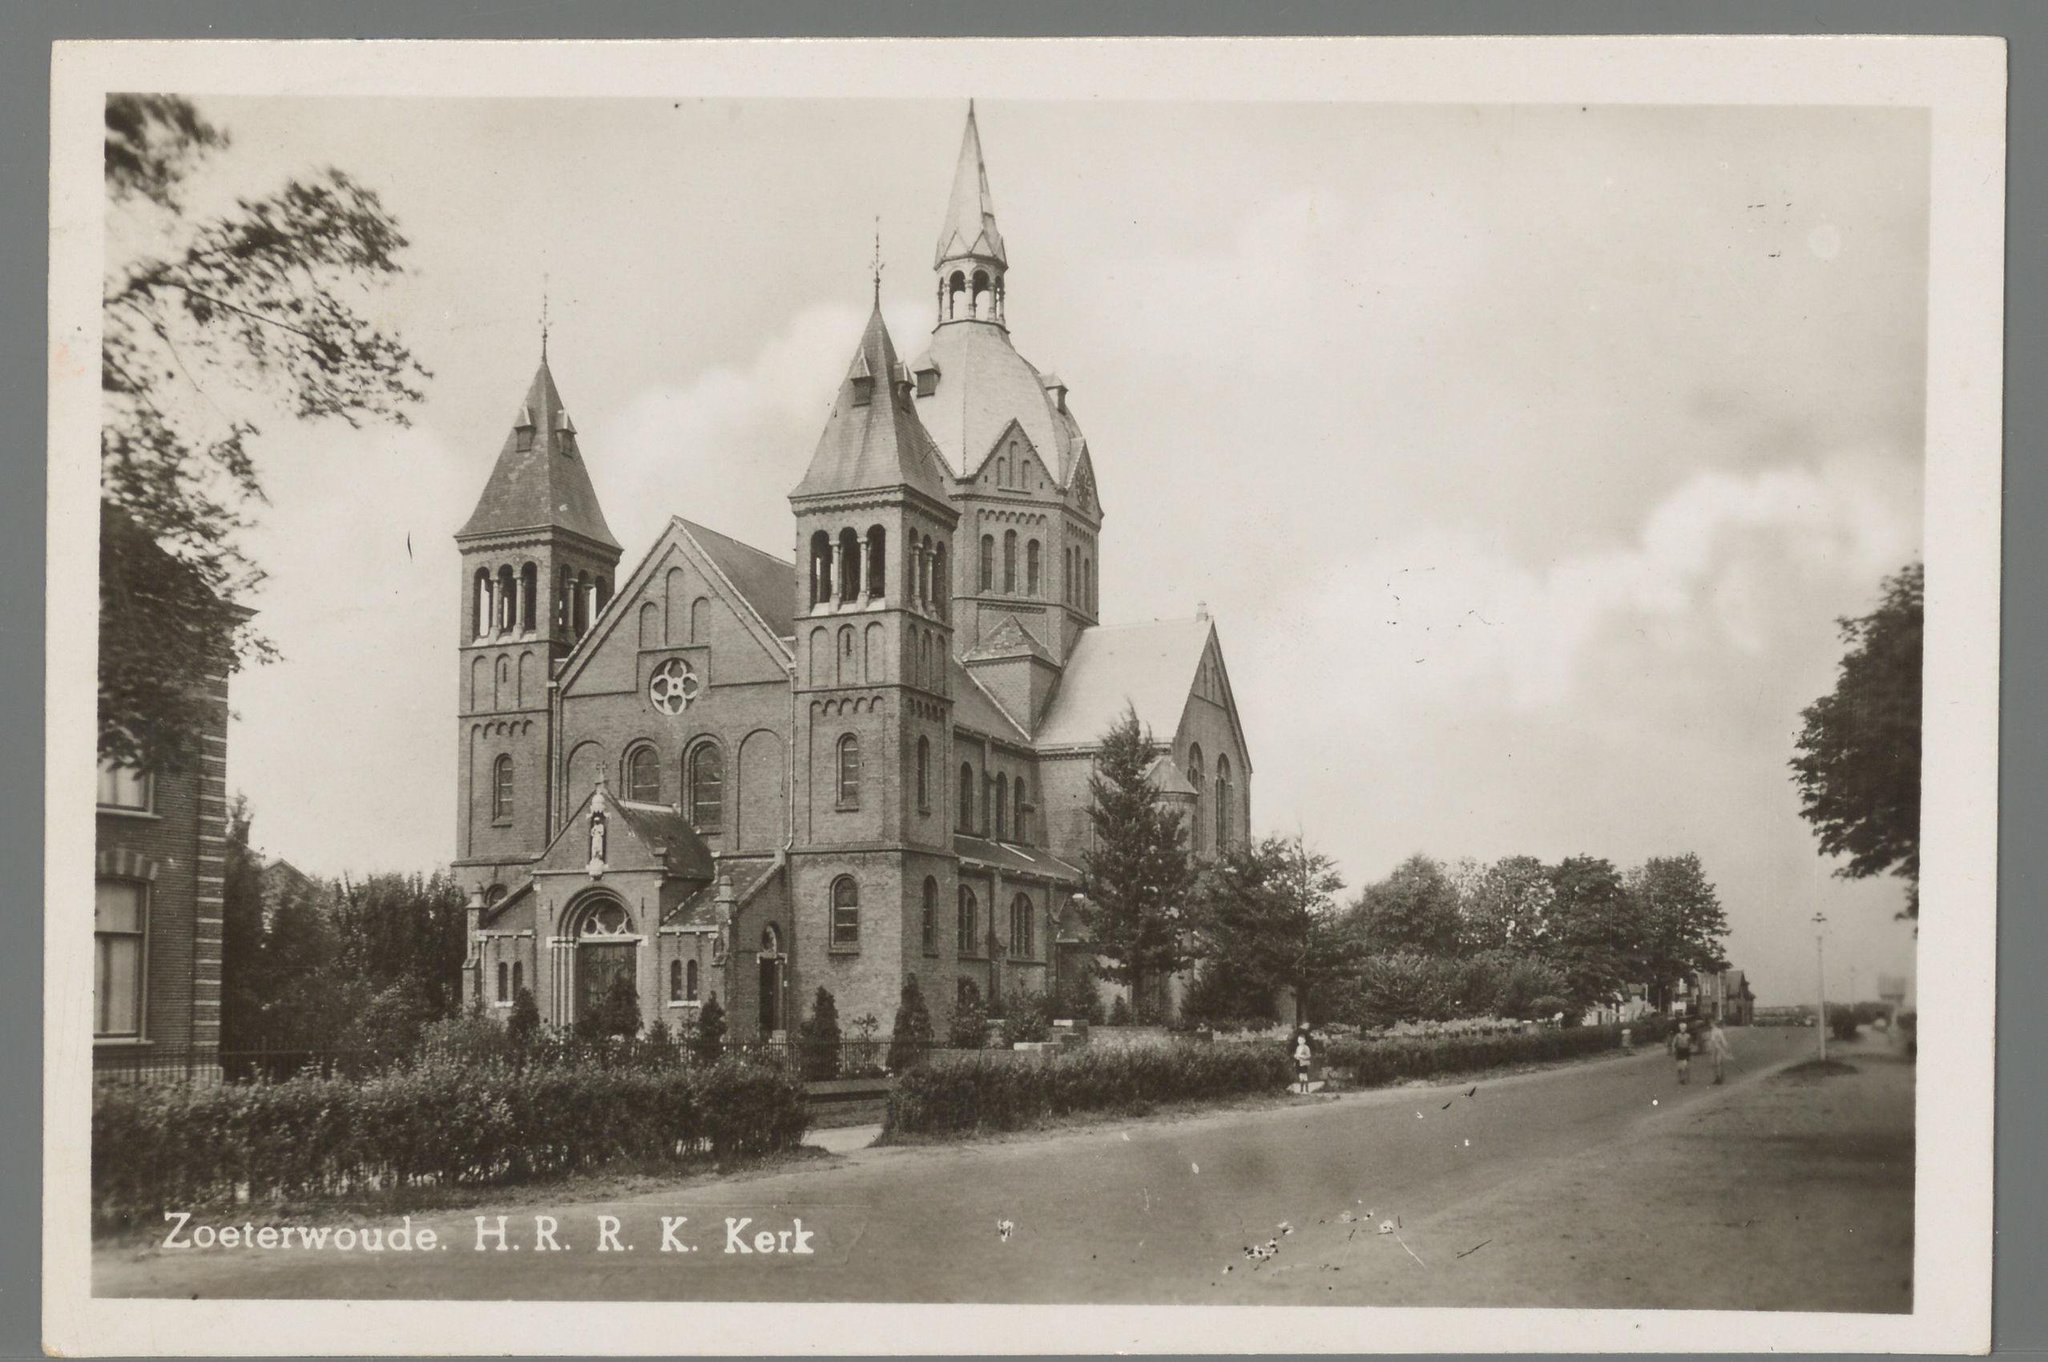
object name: photograph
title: Zoeterwoude. H. R. R. K. Kerk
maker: Anonymous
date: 1900-1930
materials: photographic support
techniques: photography, writing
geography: leiderdorp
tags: city-view in general; 'veduta', church (exterior) - qq - small church, chapel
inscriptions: postage stamp